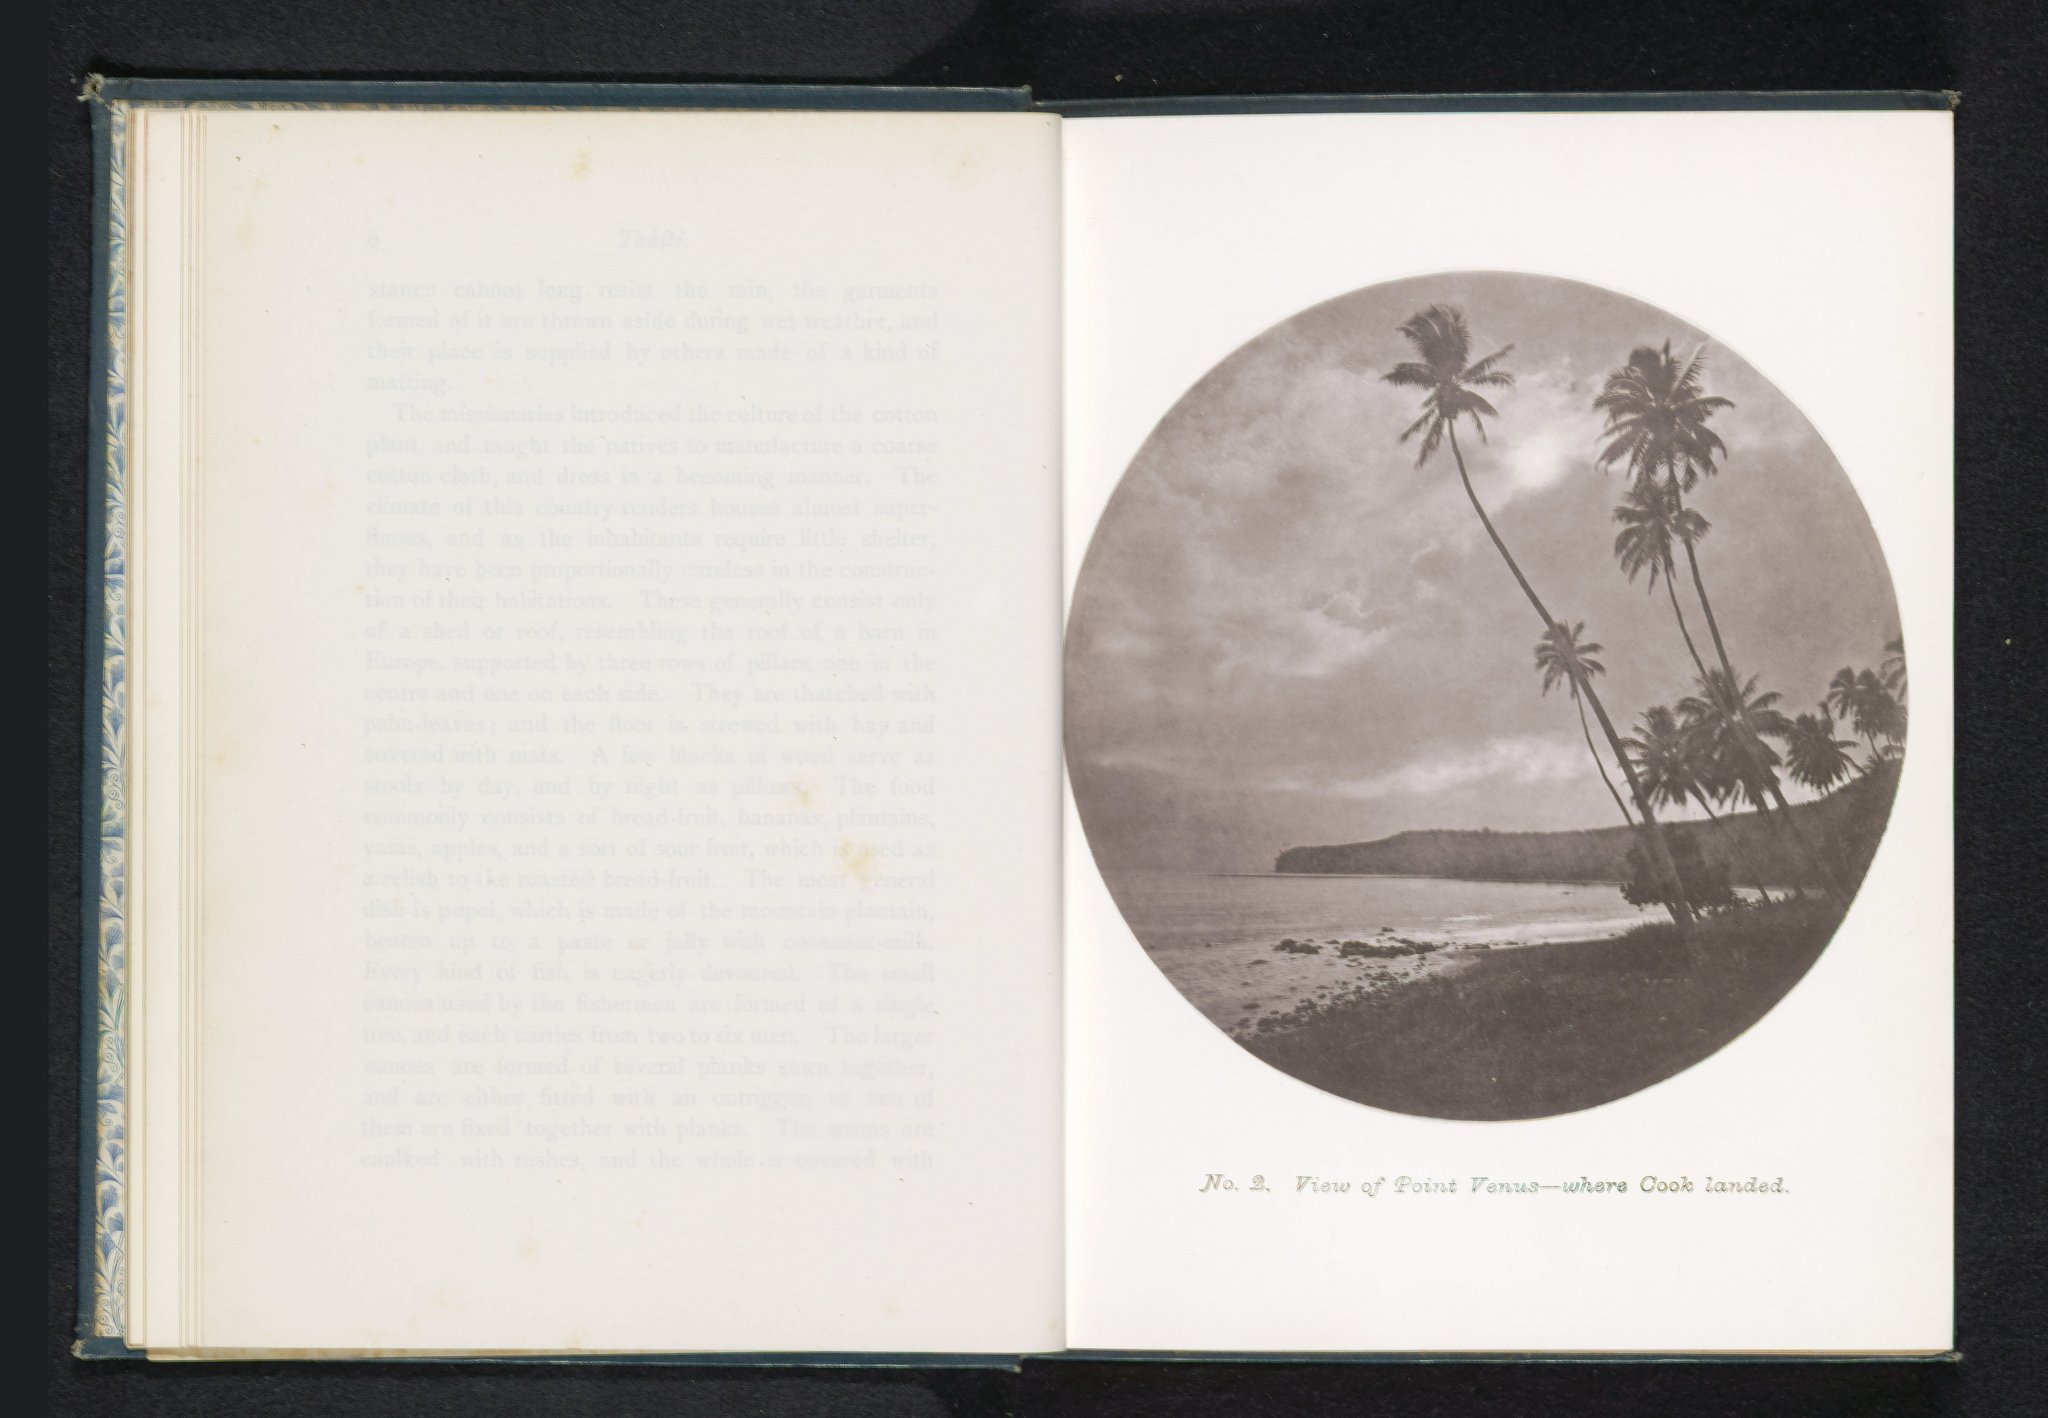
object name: photomechanical print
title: Gezicht op een strand, Point Venus, met palmbomen op Tahiti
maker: henry stuart-wortley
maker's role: fotograaf, kolonel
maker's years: 1832-1890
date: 1880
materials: paper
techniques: photograph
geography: tahiti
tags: trees: palm-tree, beach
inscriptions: number: ‘No. 2.’